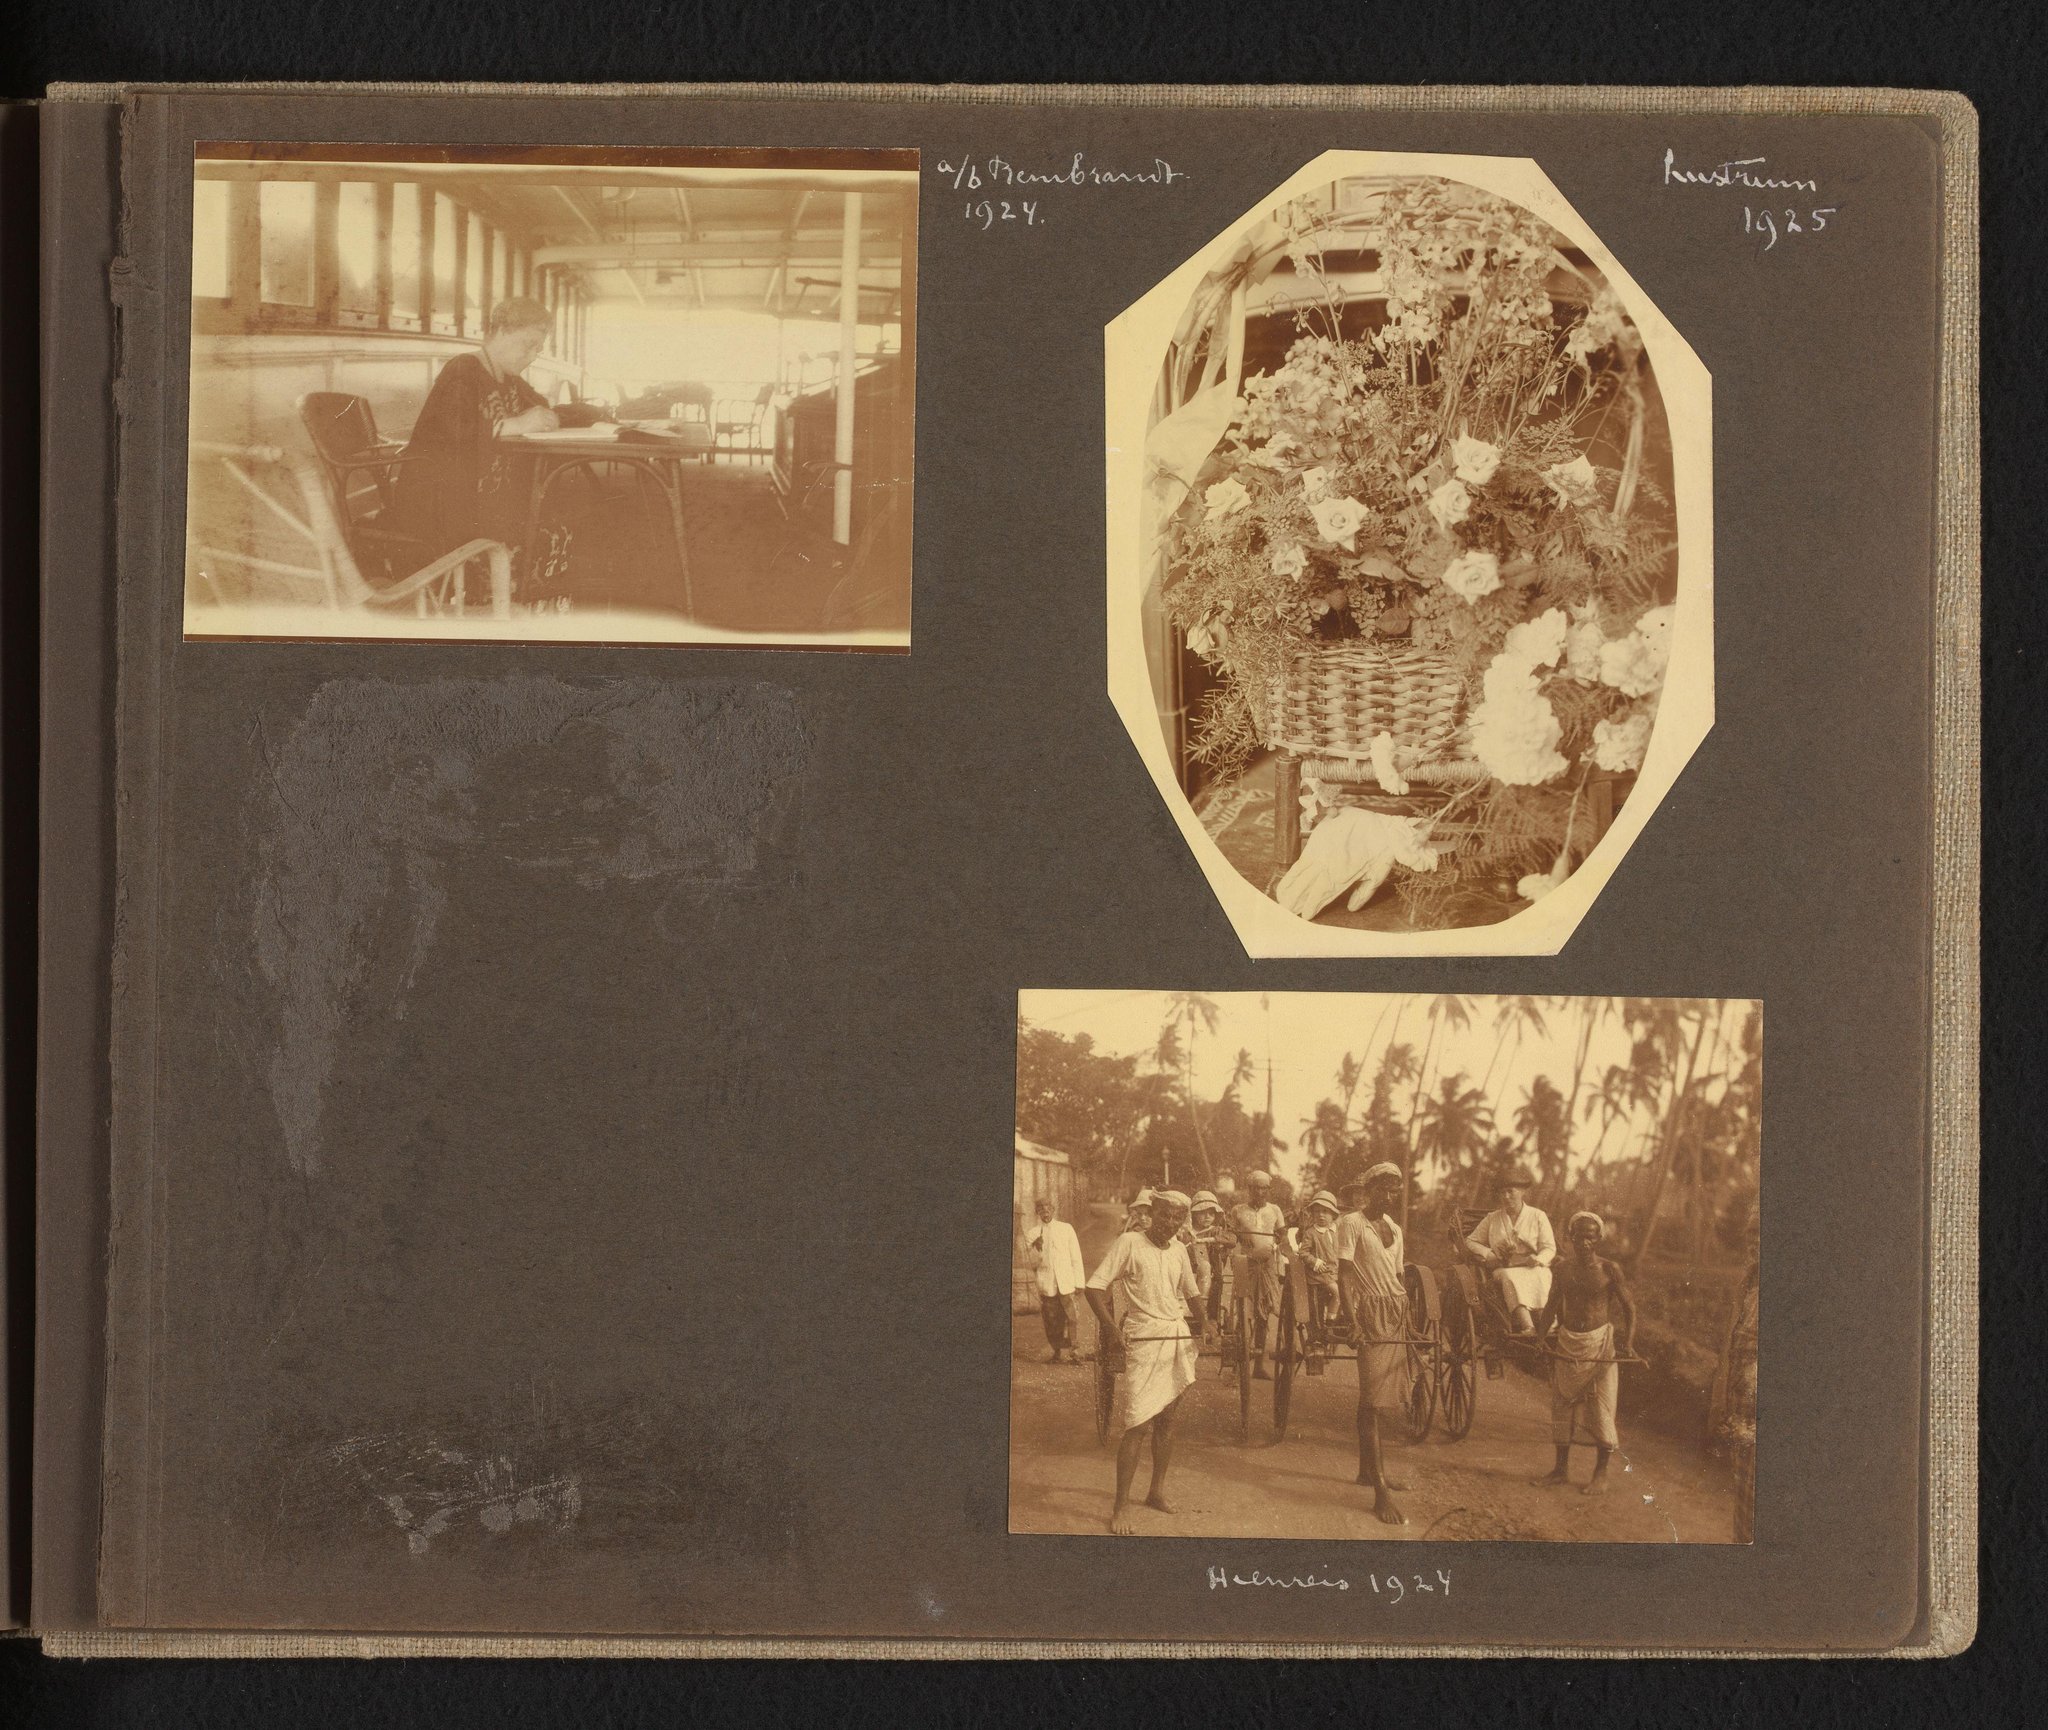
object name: album leaf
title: Schrijvende vrouw, boeket voor een lustrum en mannen met passagiers in handkarren in de voormalige kolonie Nederlands-Indië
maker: elisabeth de jong-van tonderen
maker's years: 1864-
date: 1924-1925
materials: paper, cardboard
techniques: collodion silver print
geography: dutch east indies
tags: elisabeth de jong-van tonderen, cut flowers; nosegay, bunch of flowers, writing and letters, passenger carriage, dutch east indies, the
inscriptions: inscription: ‘Heenreis 1924’, inscription: ‘a/b Rembrandt/ 1924’, inscription: ‘Lustrum/ 1925’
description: De schrijvende vrouw is aan boord van het schip 'Rembrandt van Rijn'. In één van de handkarren zit Elisabeth de Jong-van Tonderen, de stiefmoeder van Johanna (Hans) de Jong. Deze foto's maken deel uit van een album.